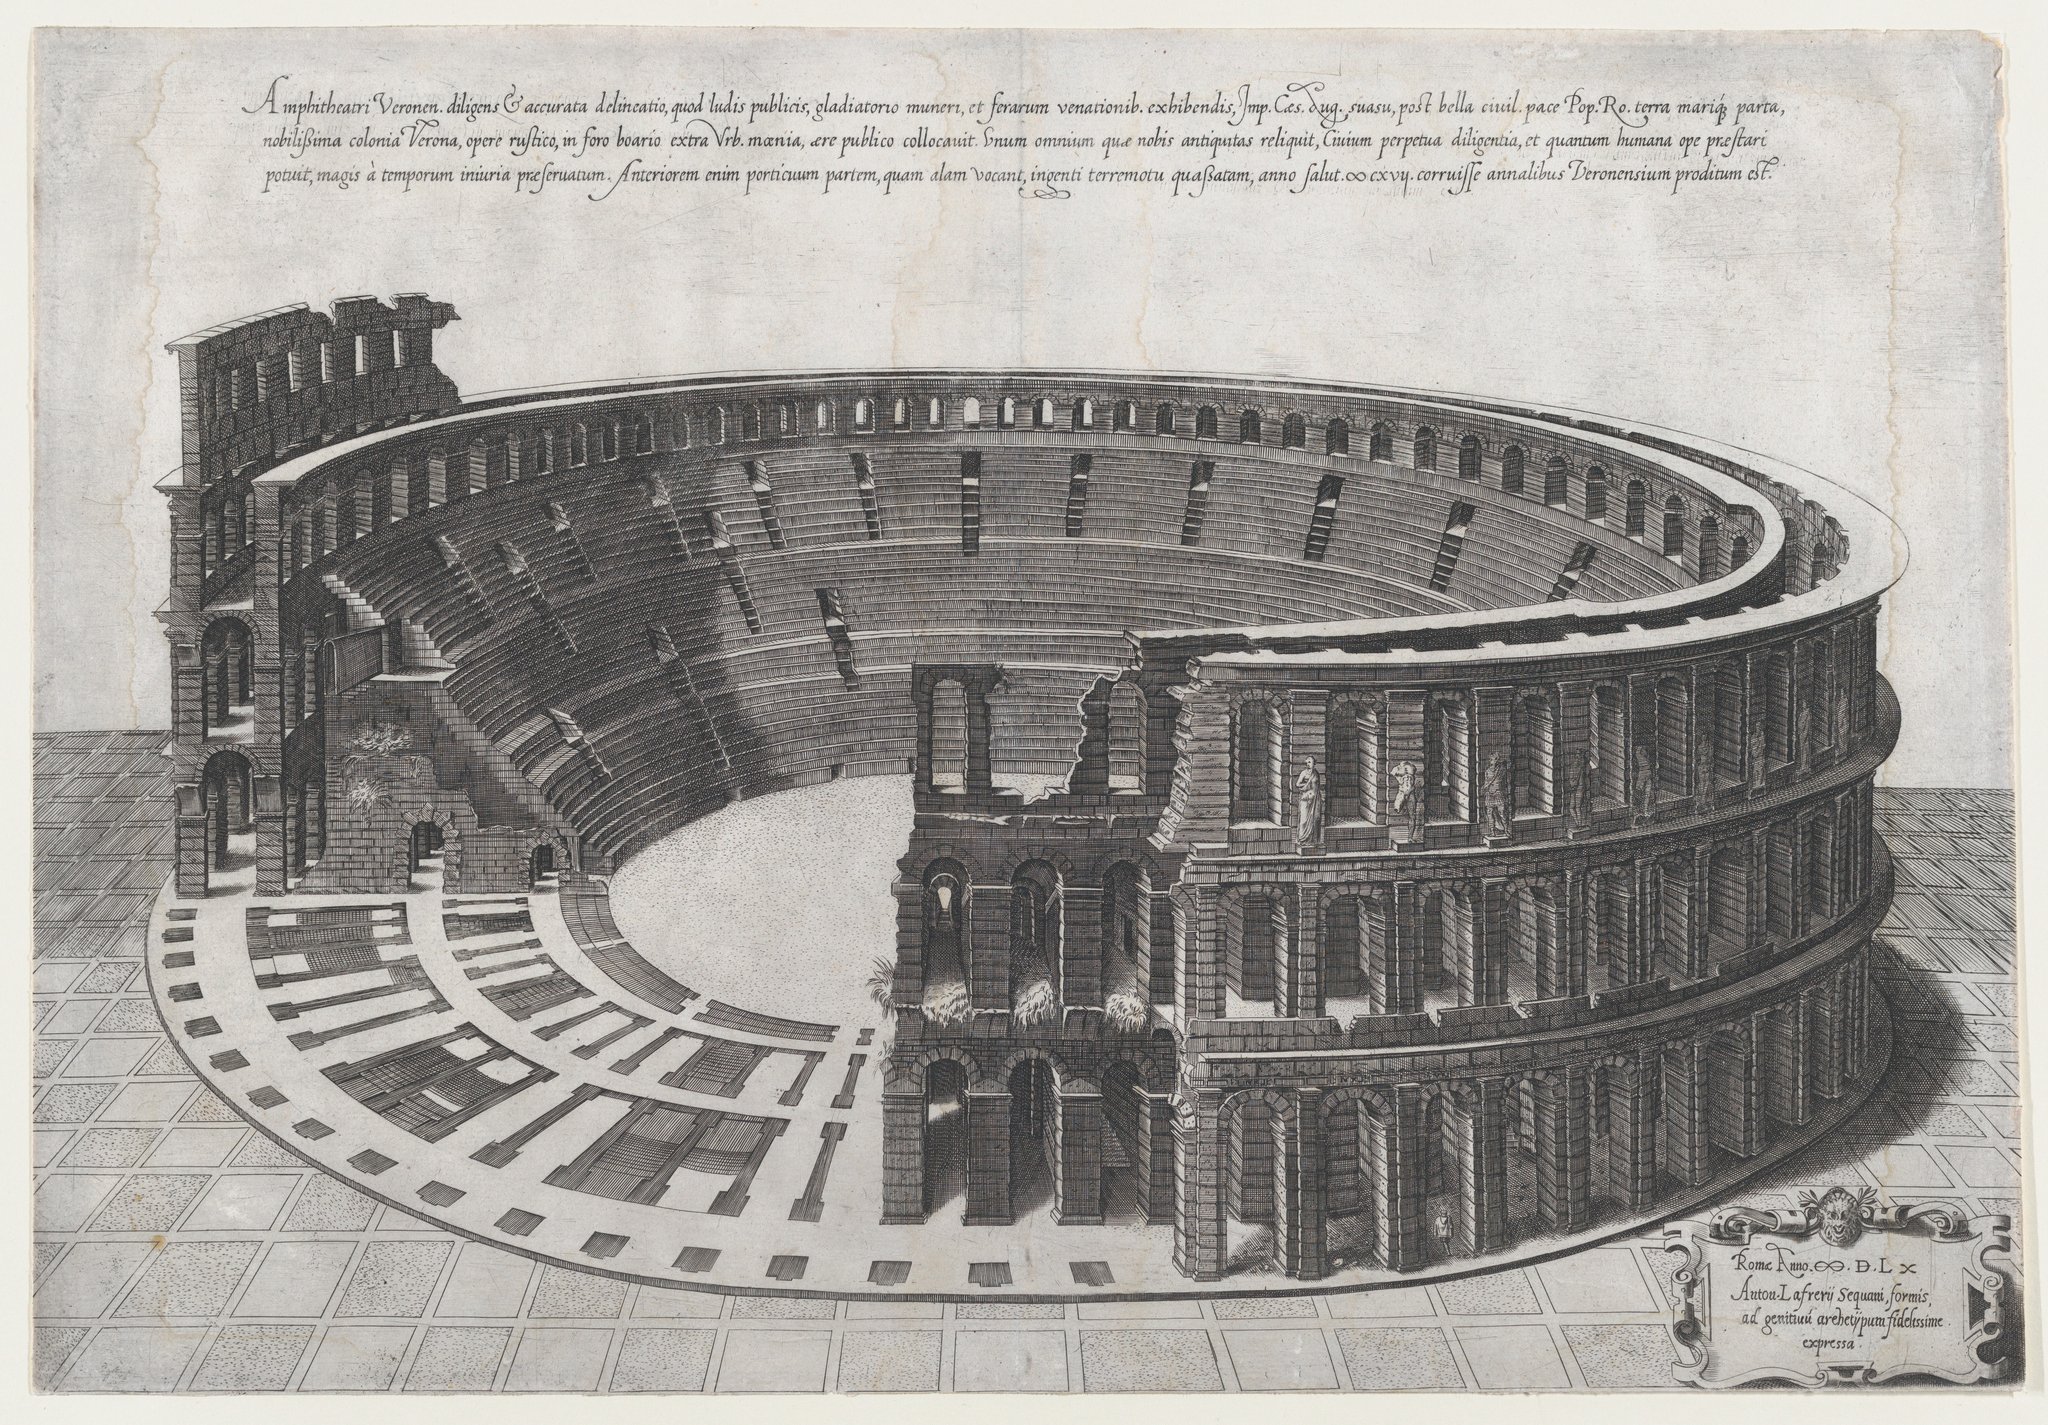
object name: print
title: Amphitheater at Verona, from "Speculum Romanae Magnificentiae"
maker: Anonymous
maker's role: artist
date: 1560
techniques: engraving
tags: architecture,rome